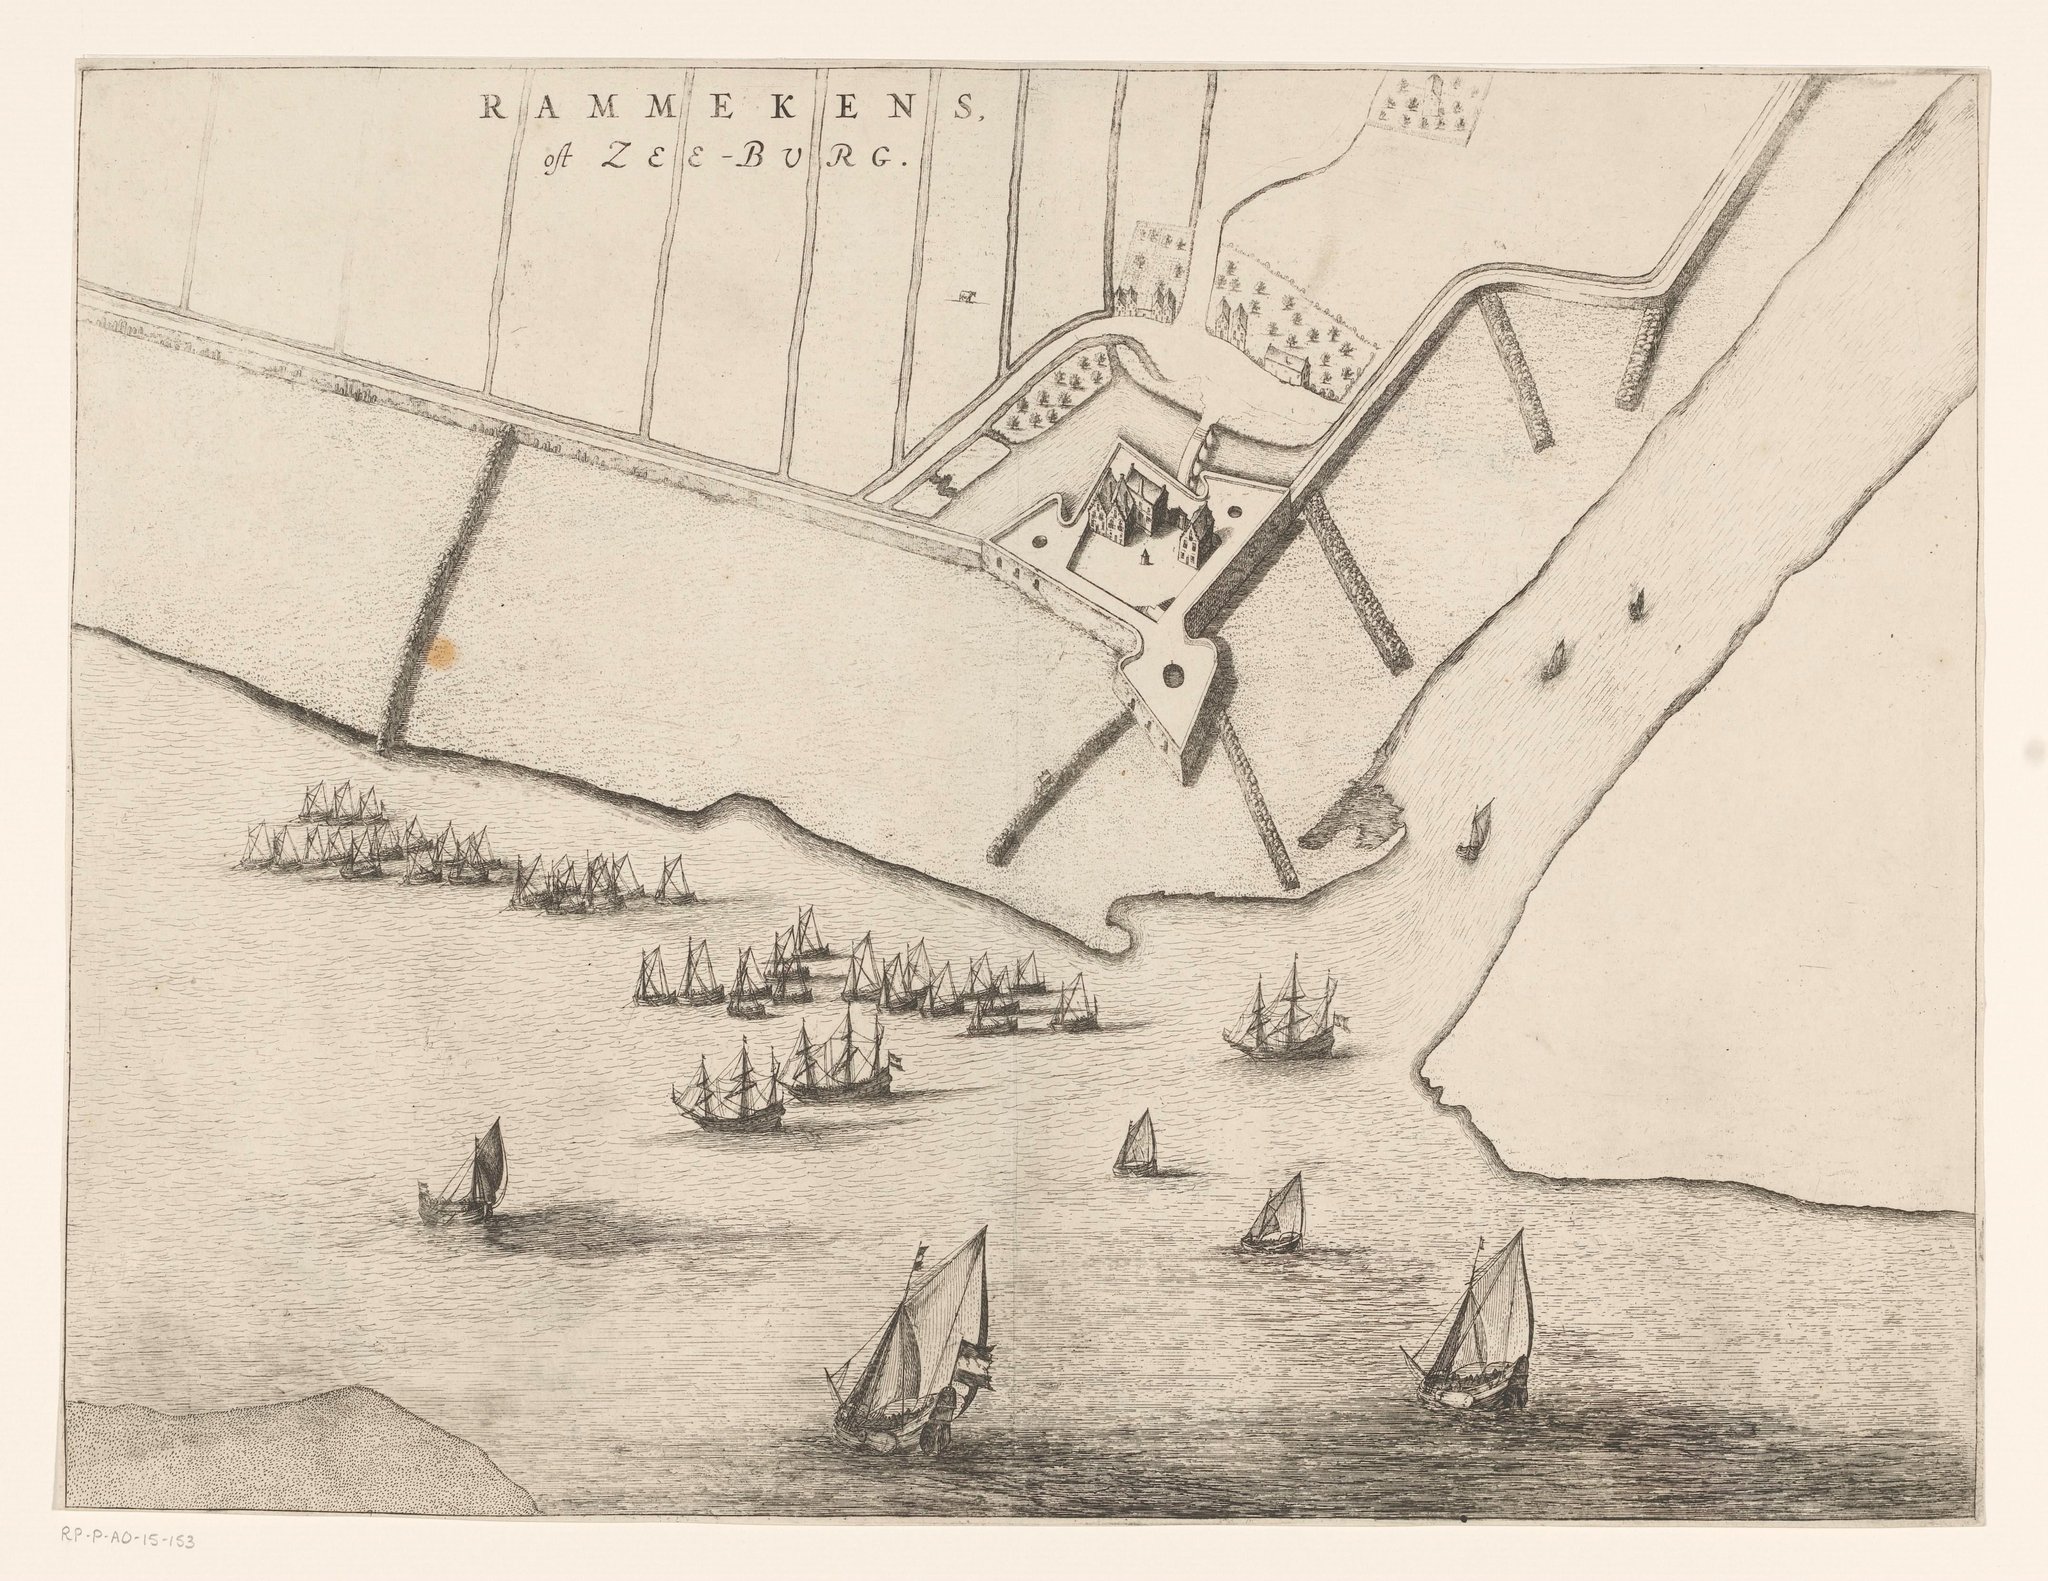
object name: print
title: Plattegrond van Fort Rammekens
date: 1649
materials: paper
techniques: engraving, etching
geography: amsterdam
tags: fortress, maps, atlases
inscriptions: collector's mark: Lugt 195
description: Deze staat van prent zonder tekst op verso (net als dit exemplaar) ook gebruikt in: Theatrum ichnographicum omnium urbium et praecipuorum oppidorum Belgicarum XVII Provinciarum (…). Amsterdam: Frederik de Wit, ca. 1698-1704.